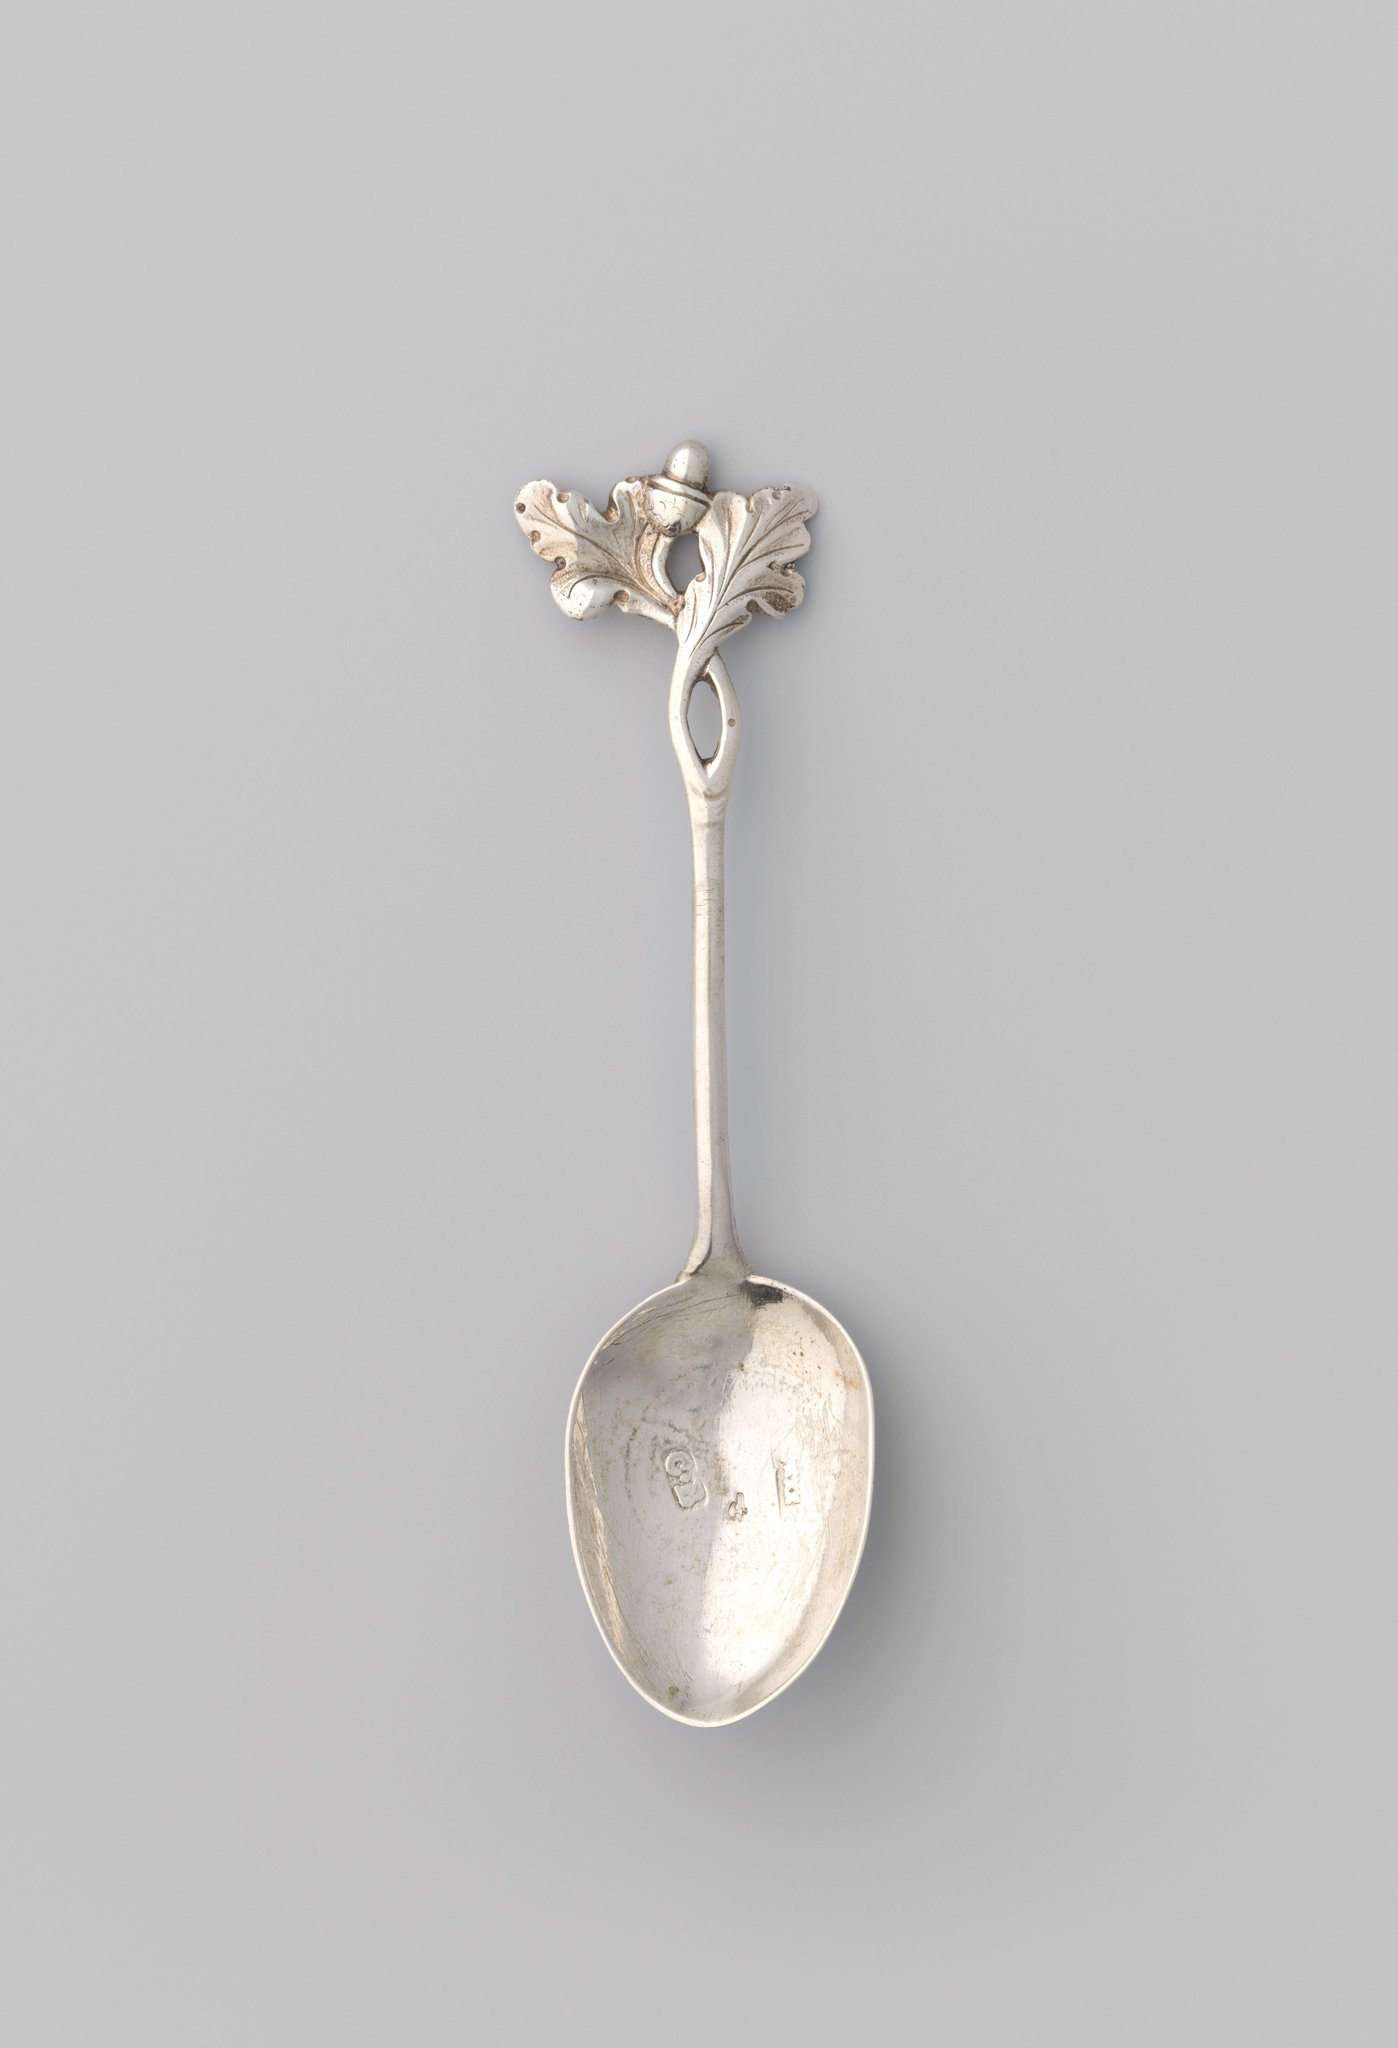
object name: spoon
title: Confiturelepel met ovale bak en steel eindigend in eikenbladeren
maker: caspar binkering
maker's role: silversmith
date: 1770-1780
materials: silver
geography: amsterdam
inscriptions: maker's mark, date letter, town mark, duty mark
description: De eivormige bak is door middel van enkel lof verbonden met de gegoten, bij de aanzet gebogen en daarna rechte, takvormige steel, die zich aan het uiteinde splitst in twee gedraaide twijgjes met eikenbladeren, met daartussen een eikeltje dat aan de onderzijde als een blaadje is versierd.